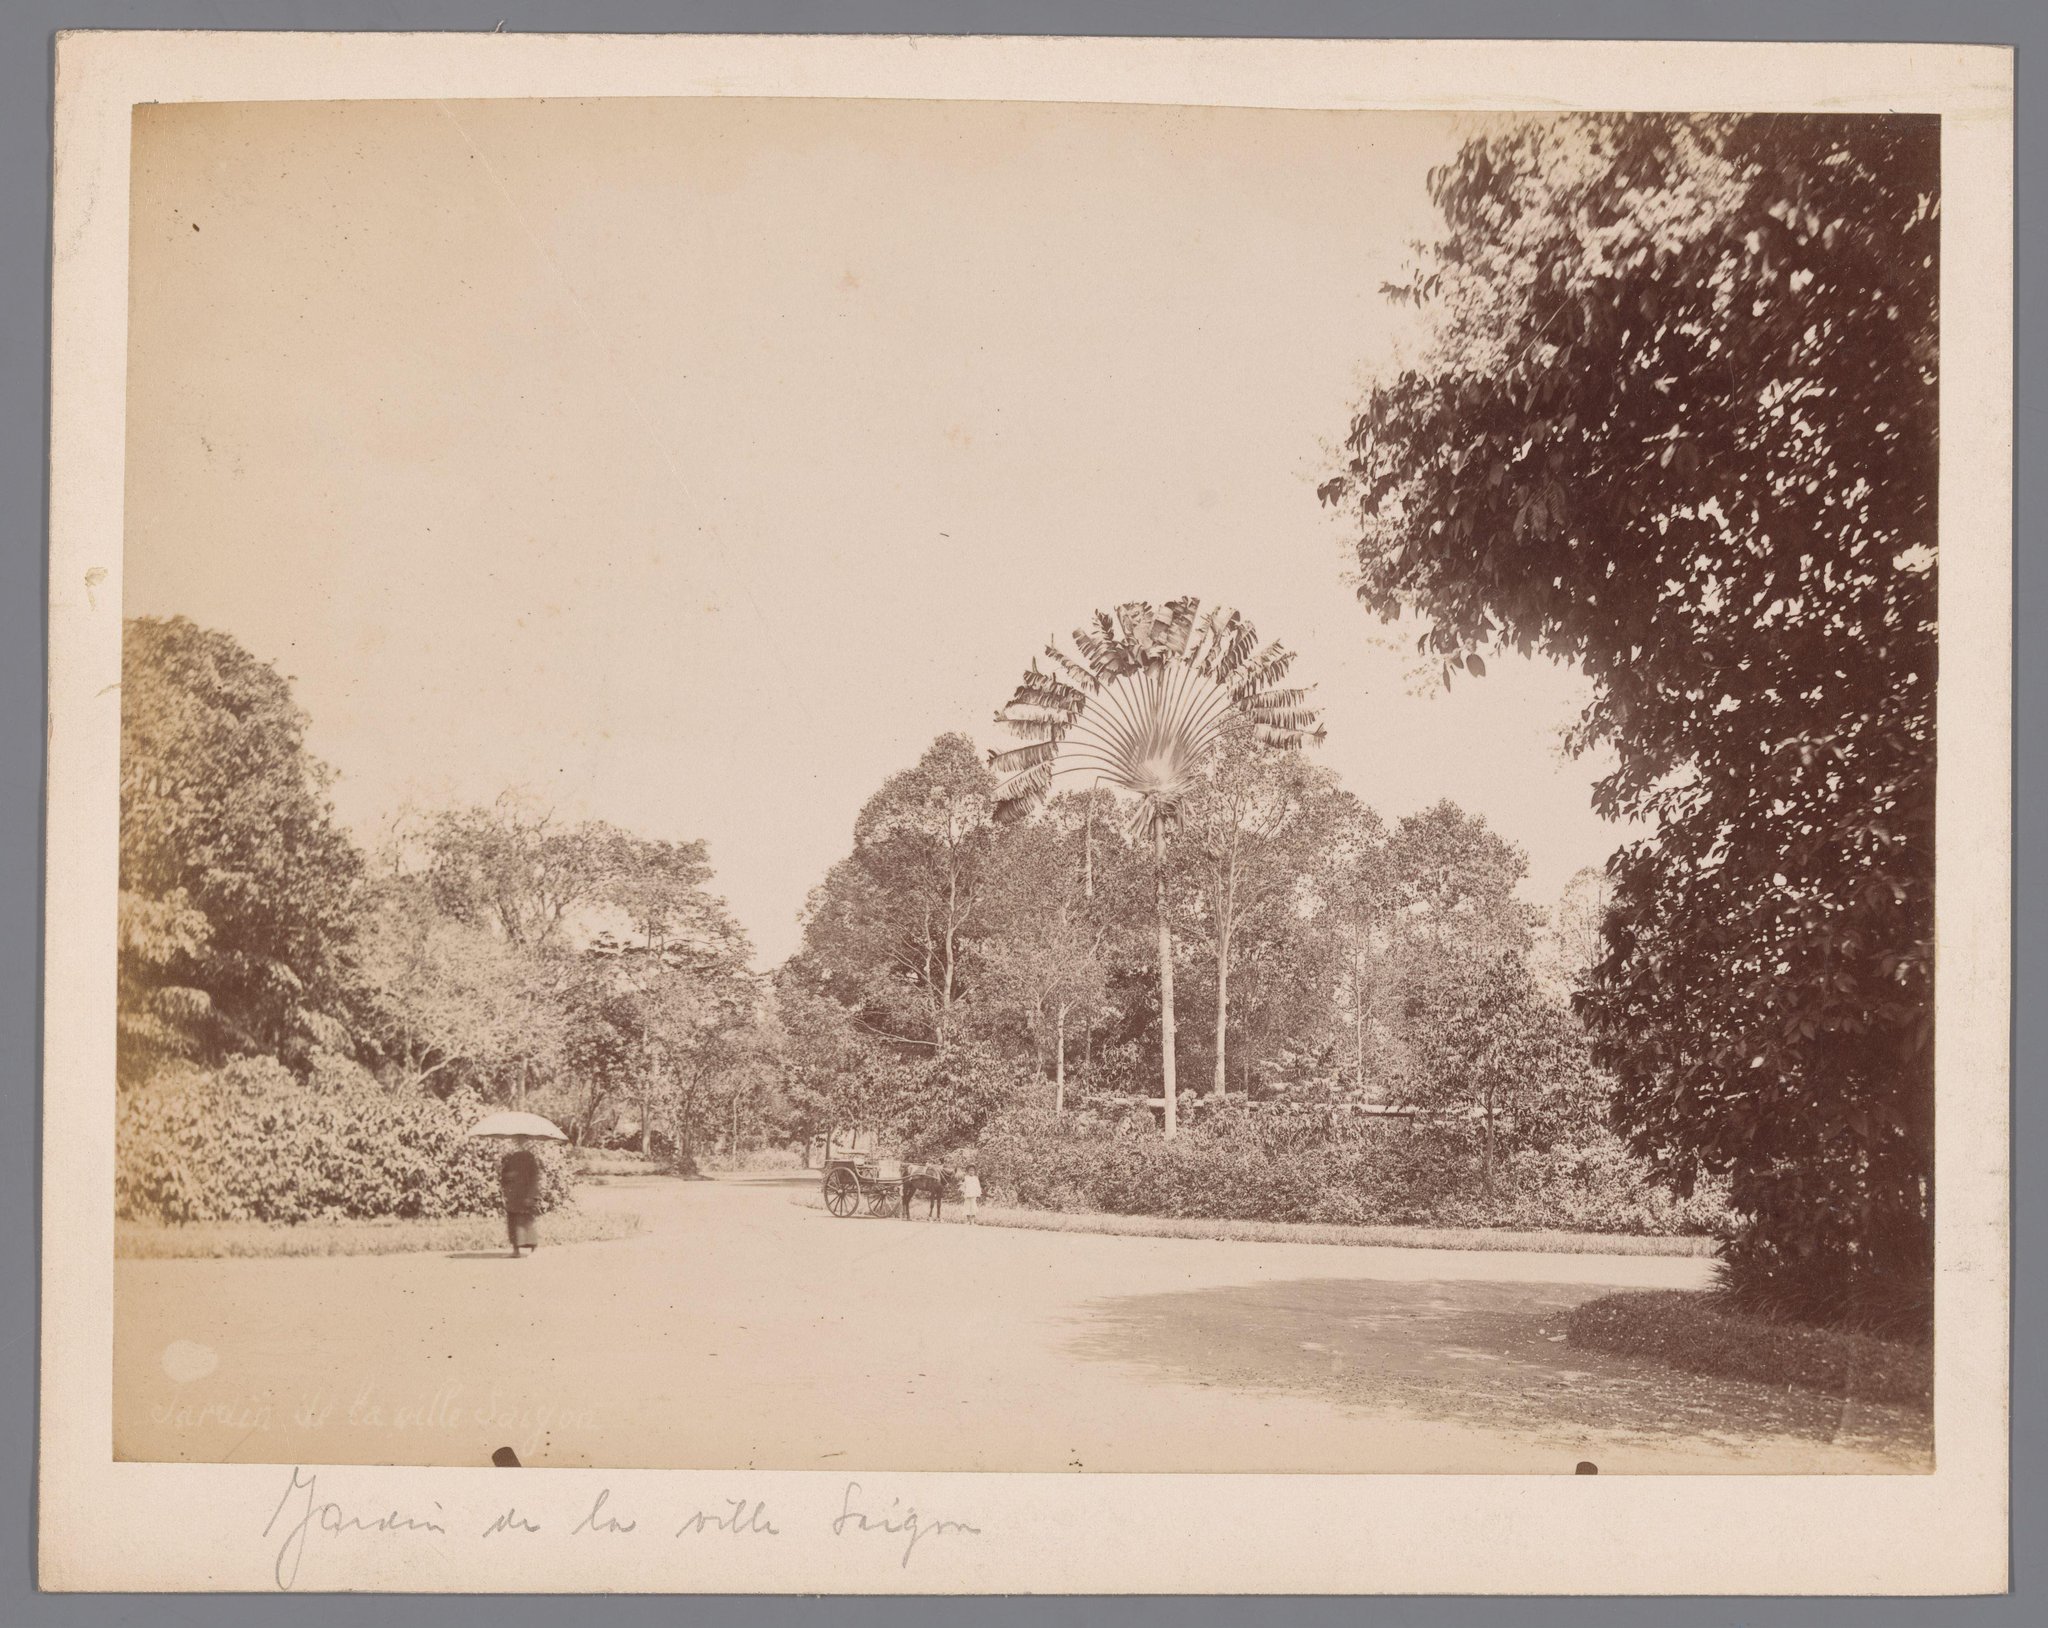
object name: photograph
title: Gezicht in de botanische tuin van Saigon (het huidige Ho Chih Minhstad)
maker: Anonymous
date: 1860-1900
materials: cardboard, paper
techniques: albumen print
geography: ho chi minh city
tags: public gardens, park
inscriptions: number: ‘62’